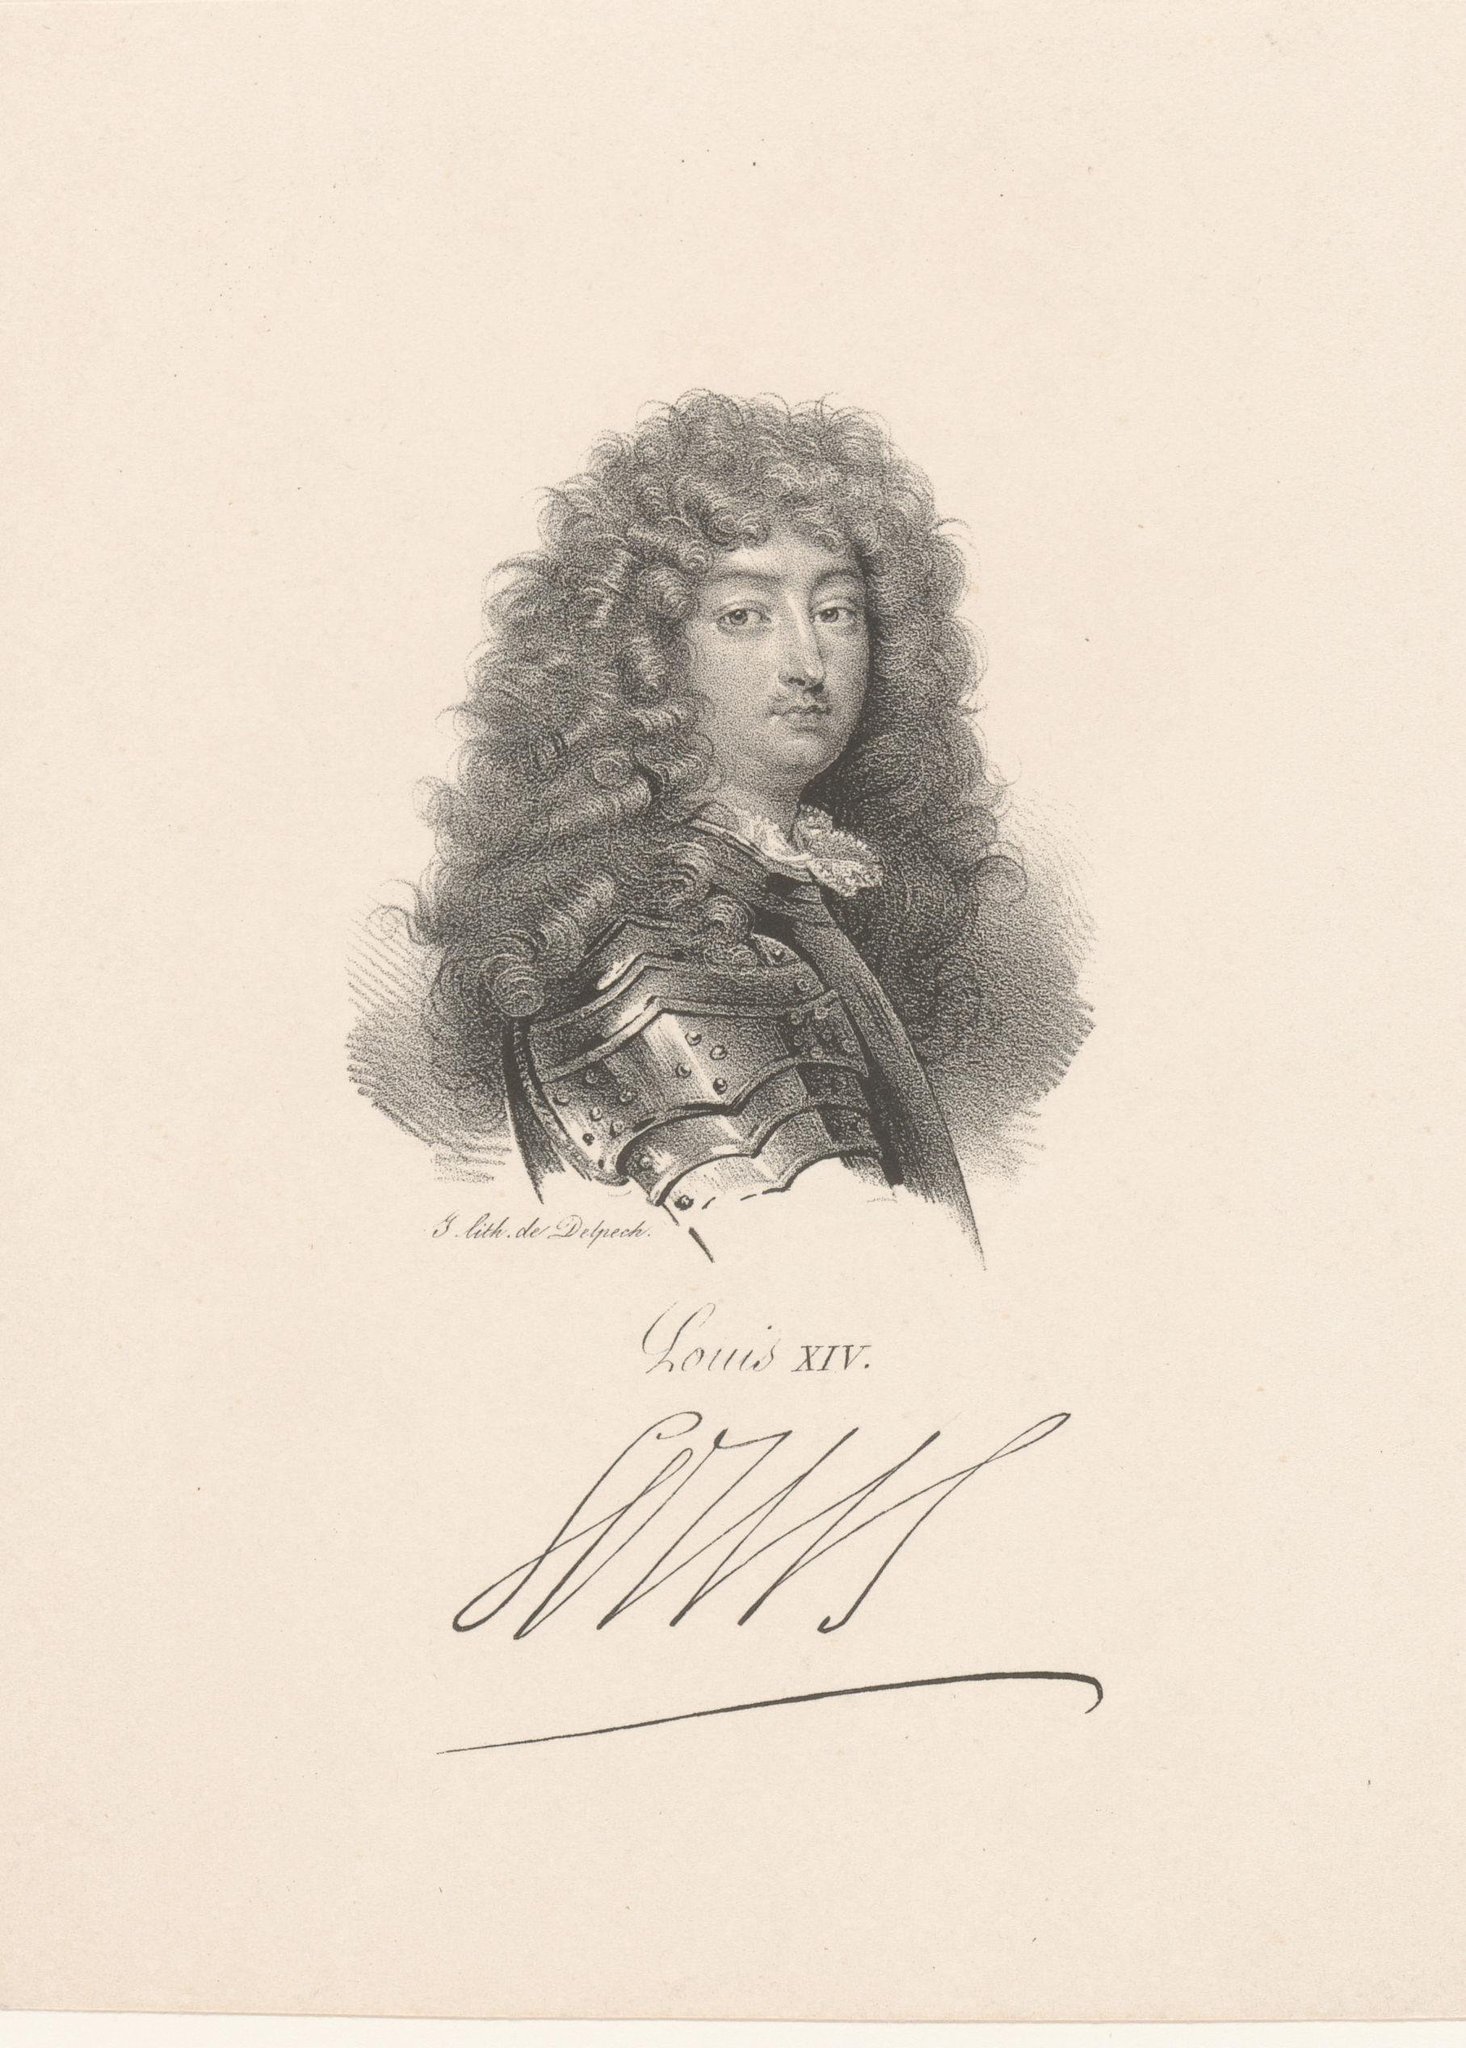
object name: print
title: Portret van Lodewijk XIV van Frankrijk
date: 1818-1842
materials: paper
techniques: lithograph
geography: paris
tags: lodewijk xiv (koning van frankrijk), historical persons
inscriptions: collector's mark: Lugt 2228a